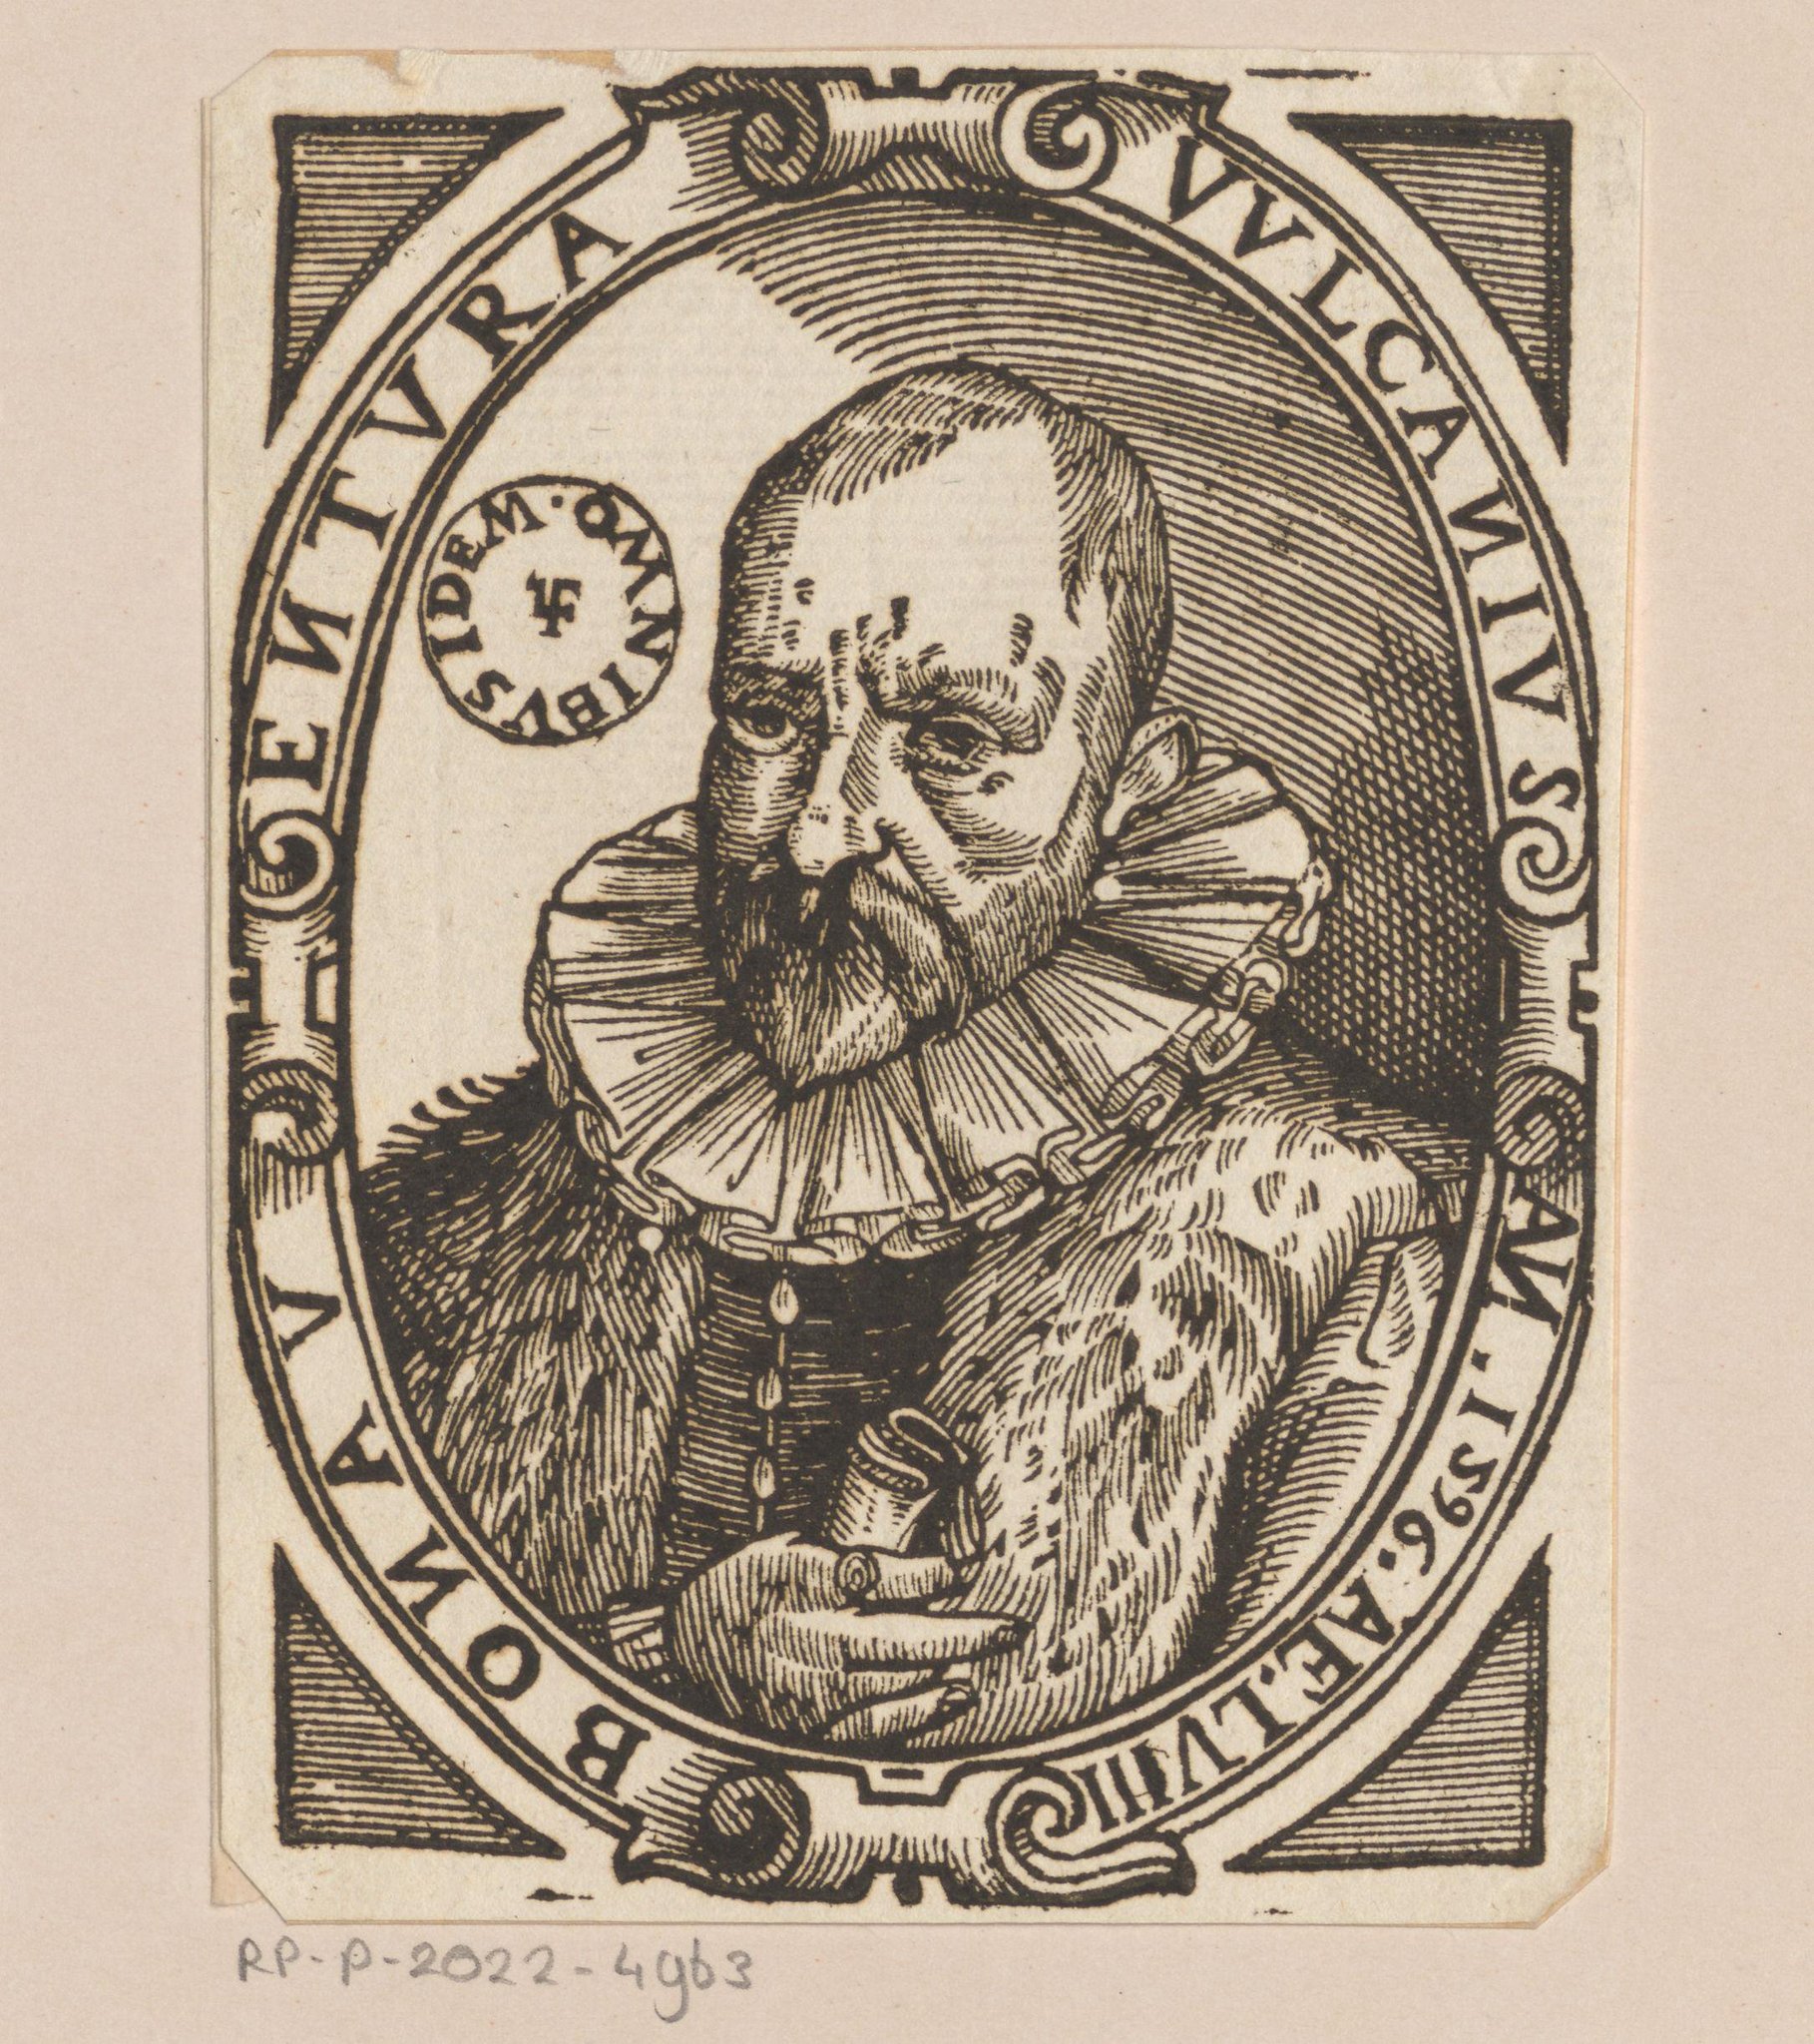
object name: print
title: Portret van Bonaventura Vulcanius op 58-jarige leeftijd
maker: Anonymous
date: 1596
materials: paper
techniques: woodcut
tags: bruges, bonaventura vulcanius, scholar, philosopher, historical persons, portrait of a writer